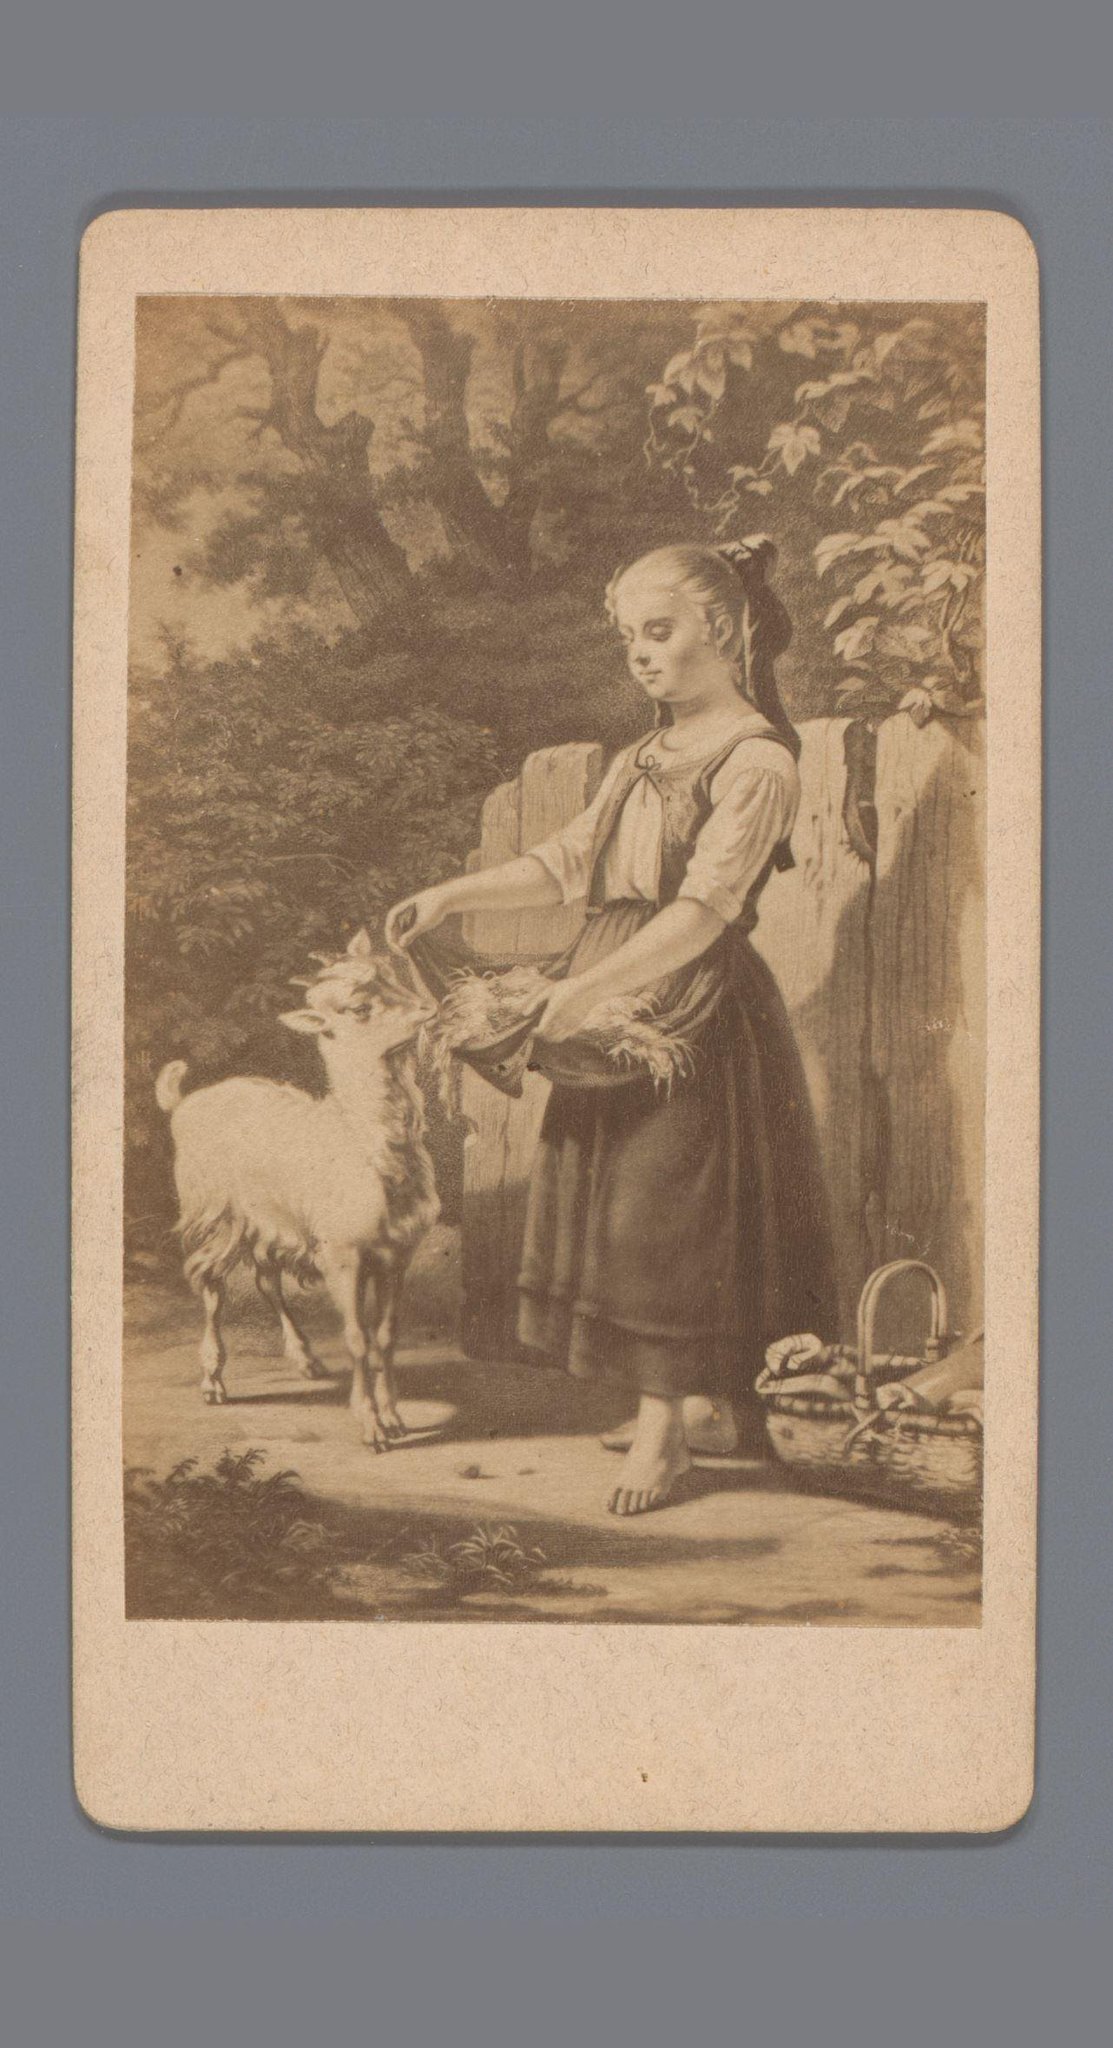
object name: photograph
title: Fotoreproductie van het schilderij Komm Hänschen van Friedrich Eduard Meyerheim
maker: Anonymous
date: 1855-1885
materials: cardboard, paper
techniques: albumen print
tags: girl (child between toddler and youth), goat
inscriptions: inscription: ‘Meyerheim.’, number: ‘No. 230.’